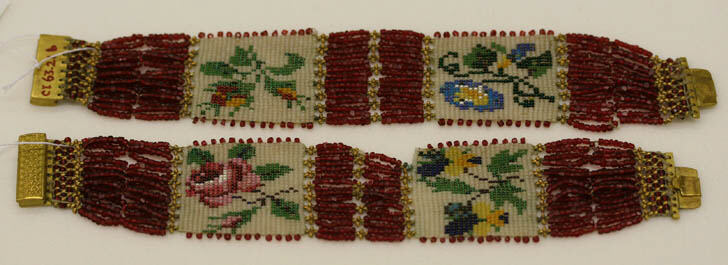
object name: bracelet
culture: british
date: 1840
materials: glass, gold